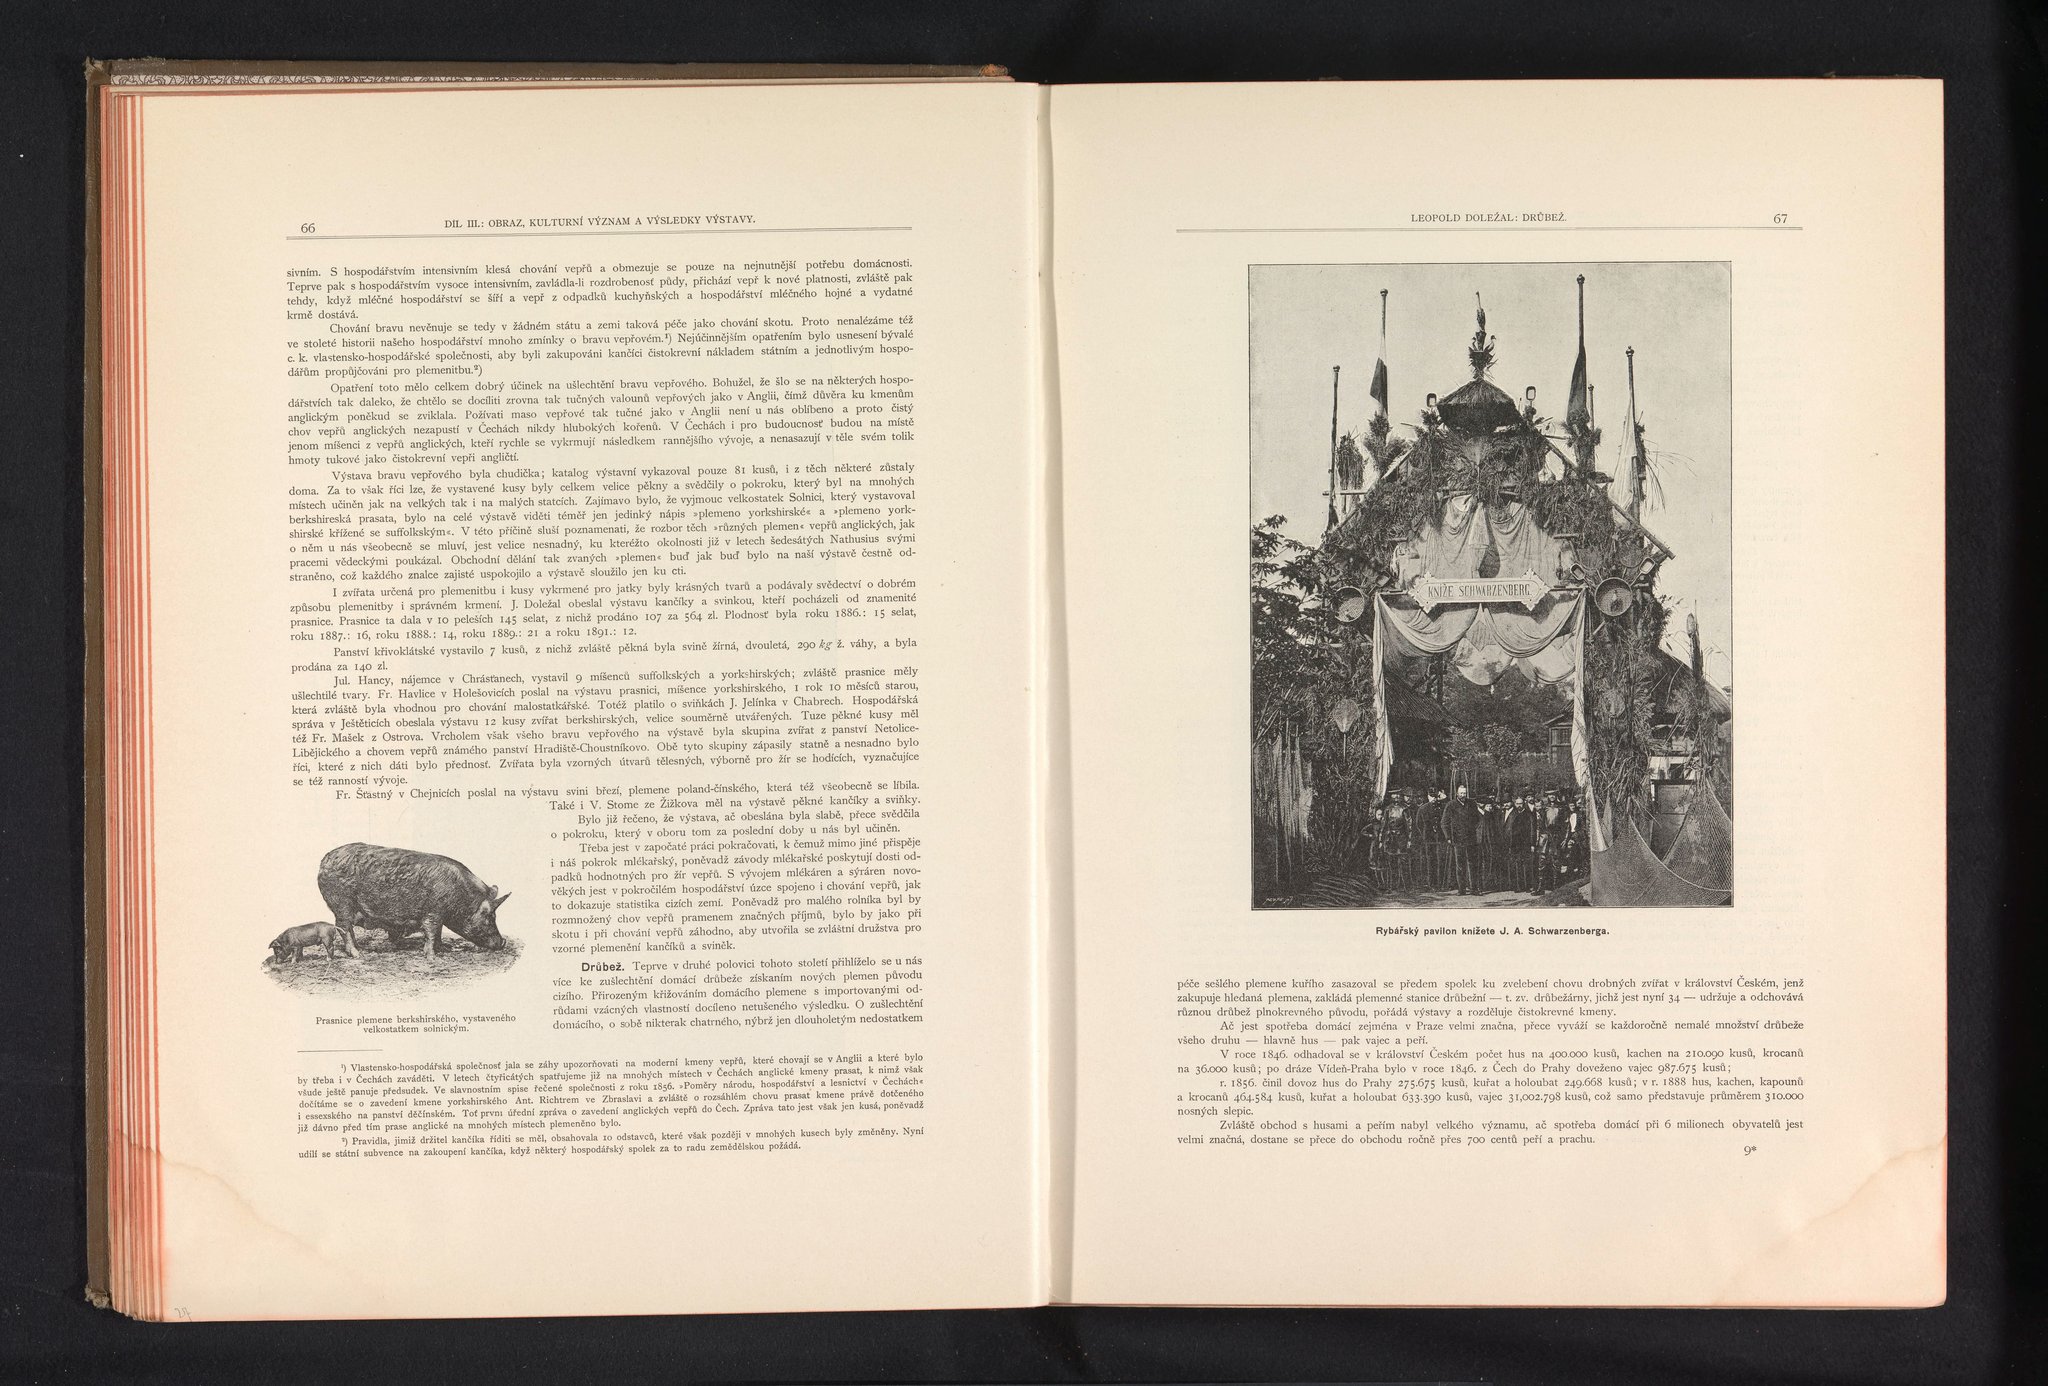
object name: page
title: Groepsportret voor het paviljoen van J. A. Schwarzenberg te Praag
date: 1891-1895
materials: paper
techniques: autotype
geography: prague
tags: façade (of house or building), anonymous historical persons portrayed in a group, in a group-portrait